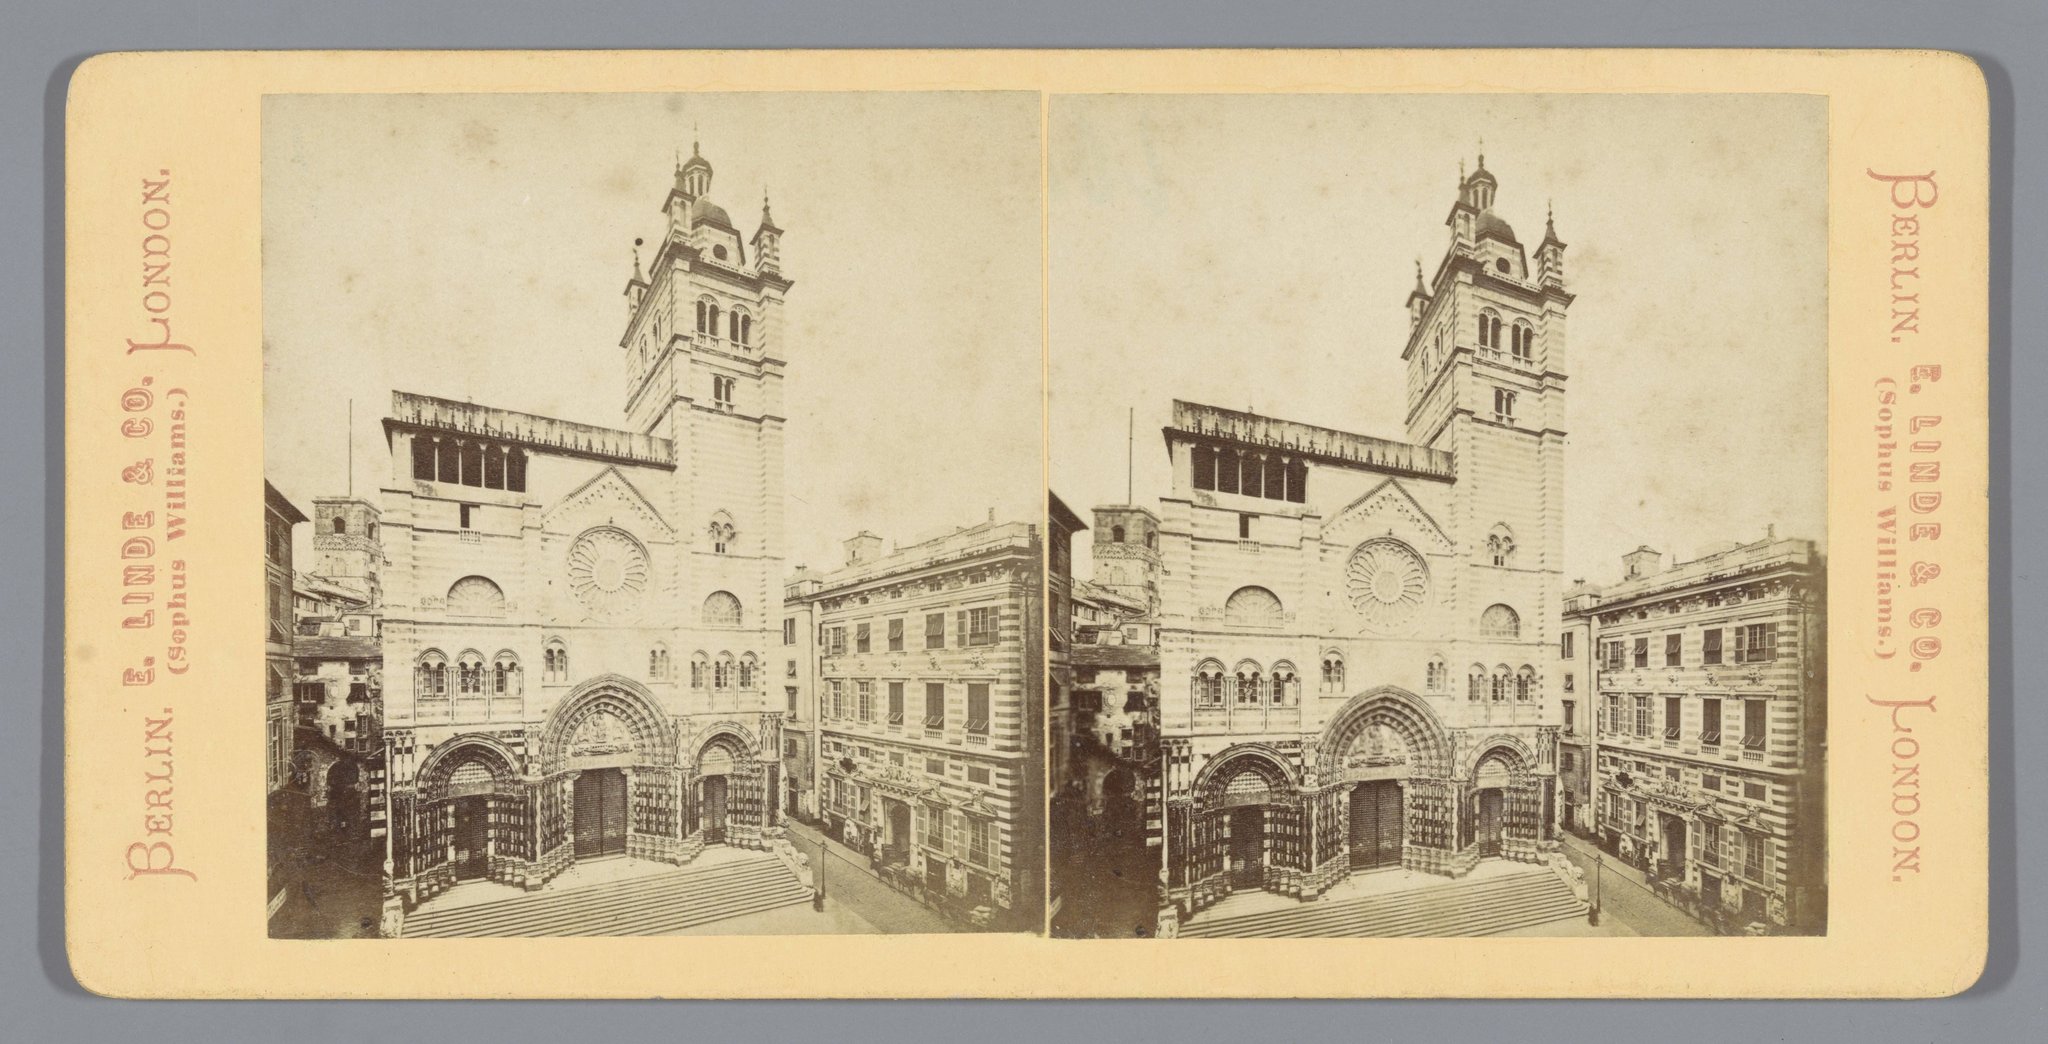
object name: stereograph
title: Exterieur van de Kathedraal van San Lorenzo in Genua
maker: alfredo noack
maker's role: fotograaf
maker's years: 1833-1895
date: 1870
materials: cardboard, photographic support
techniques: albumen print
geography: london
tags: interior of church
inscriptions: number: ‘No 101.’, name: ‘E. LINDE & CO. (Sophus Williams.) BERLIN. LONDON.’, inscription: ‘Genua. S. Lorenzo.’